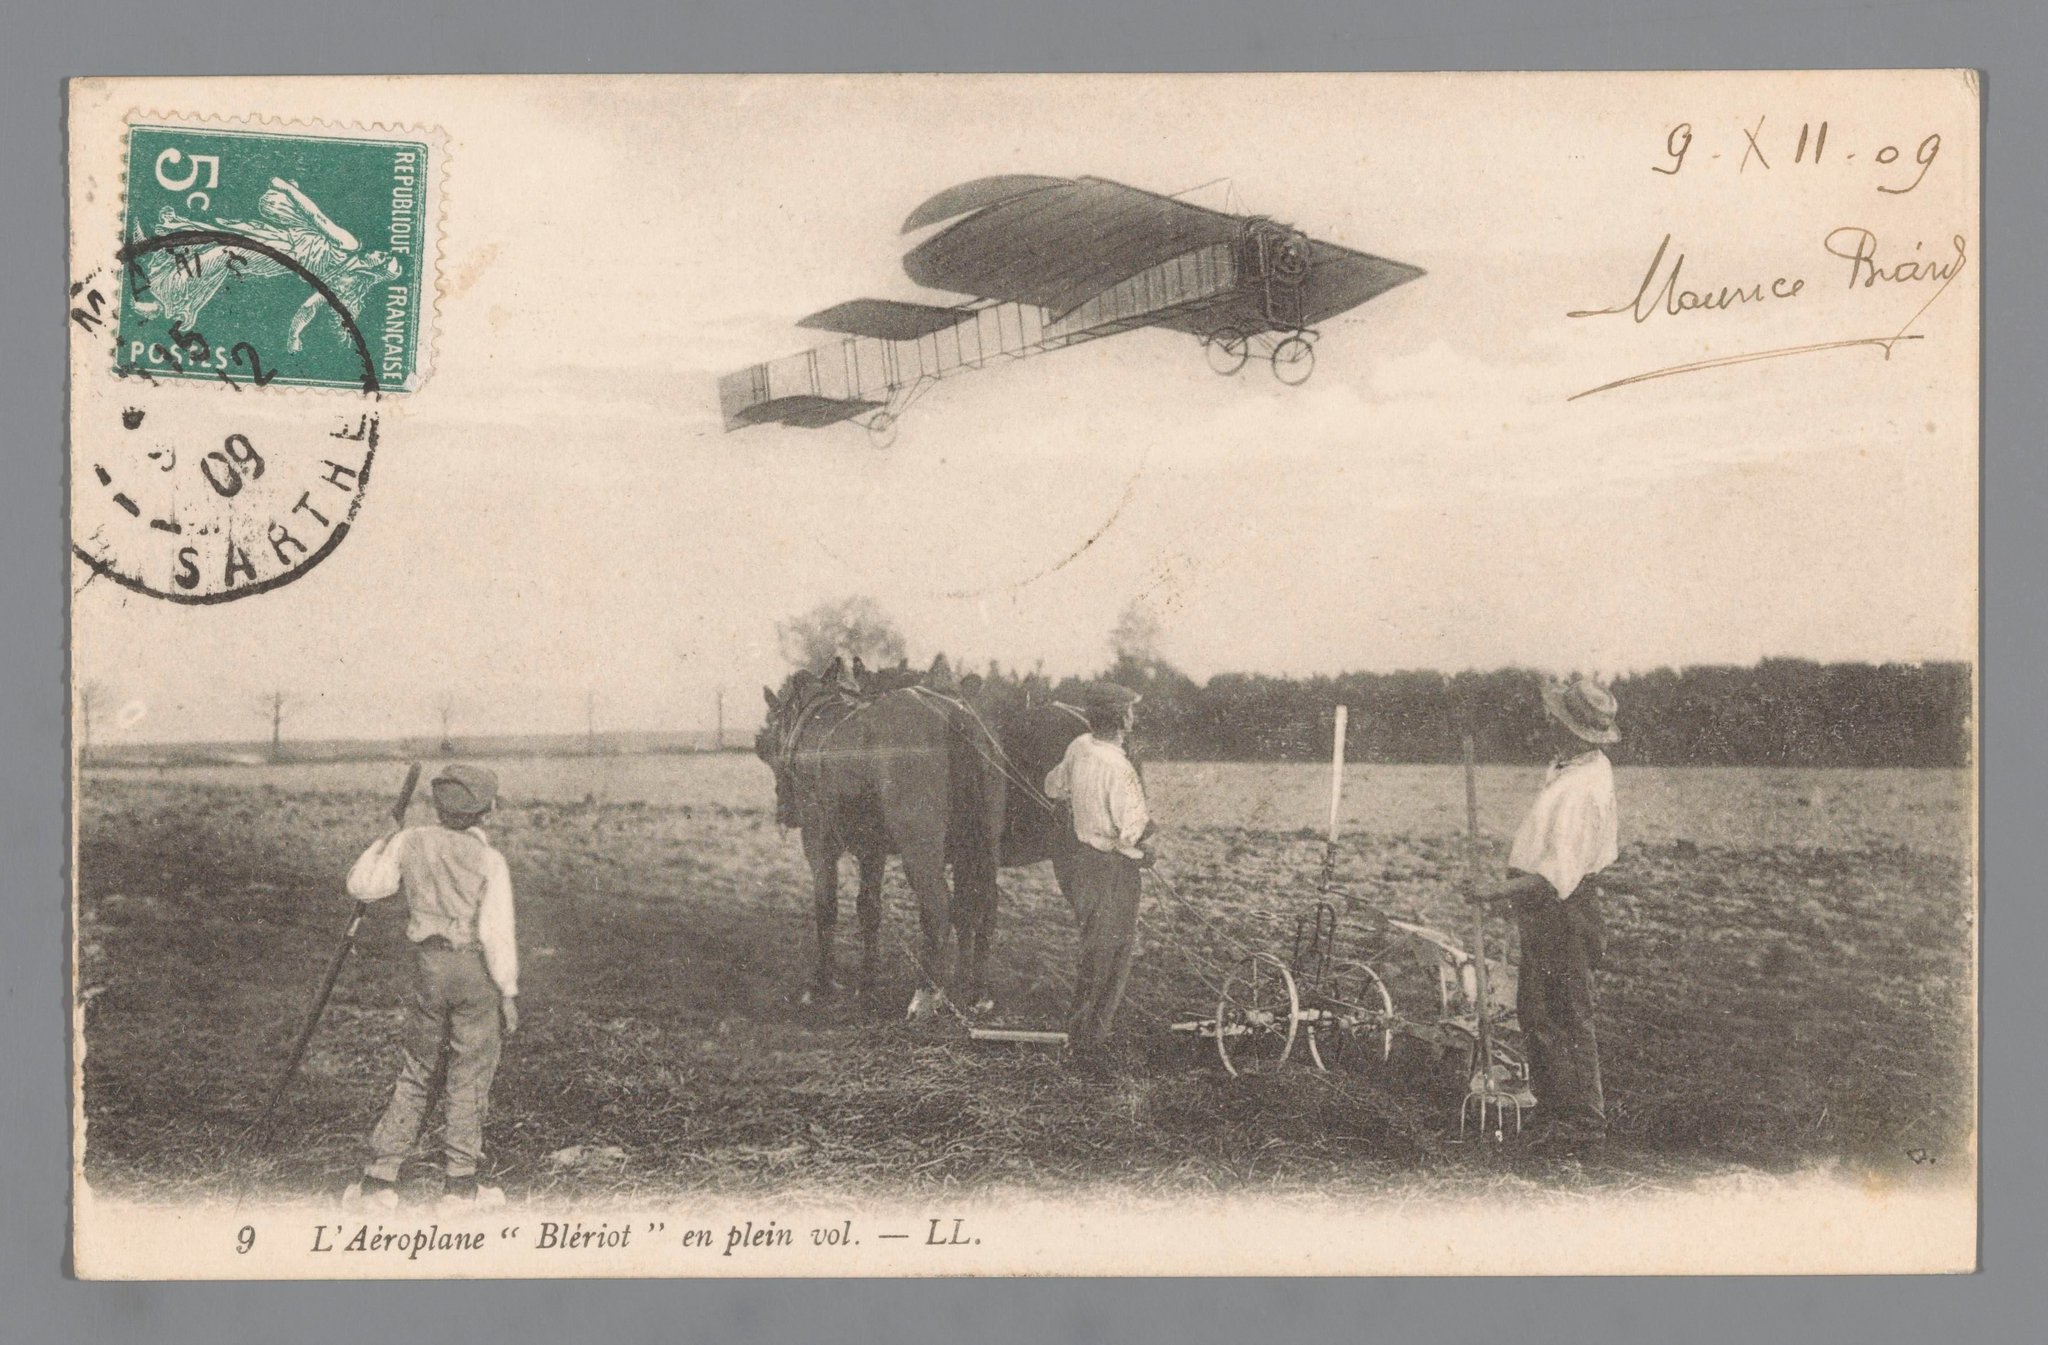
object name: ansichtkaart, prentbriefkaart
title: L'Aéroplane <Blériot> en plein vol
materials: paper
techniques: photograph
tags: aircraft, aeroplane, meadow, pasture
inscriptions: inscription: ‘Alice Berthe Jane (...) Delft Hollande’, number: ‘9’, inscription: ‘Delft 10.12.09’, inscription: ‘9. XII.09 Maurice Biard’